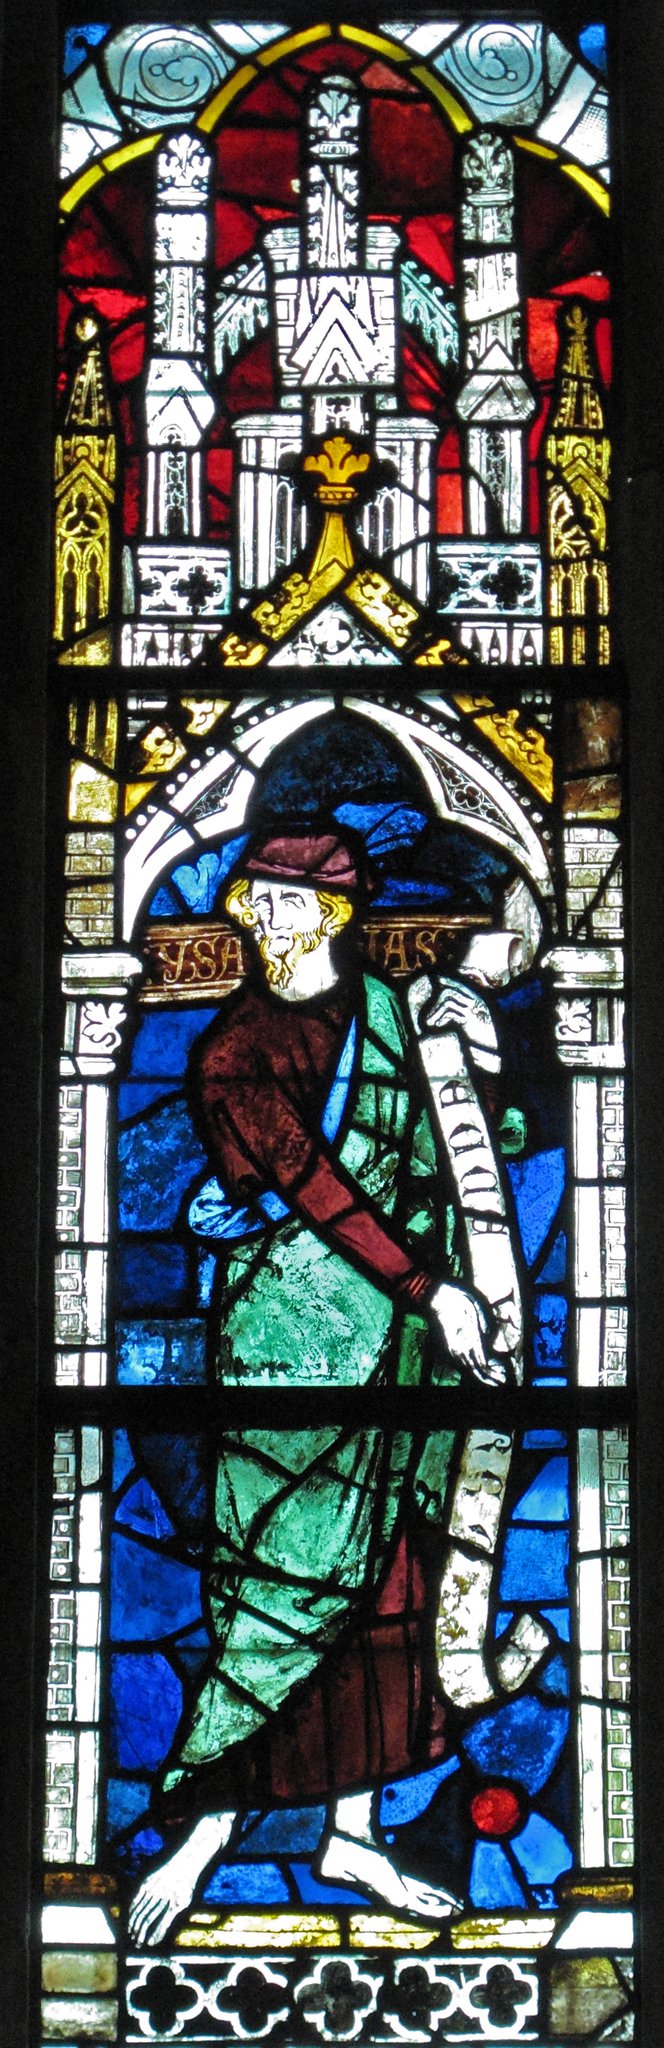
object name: stained glass panel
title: Prophet Isaiah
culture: french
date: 1325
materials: glass, metal, paint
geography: france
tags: men